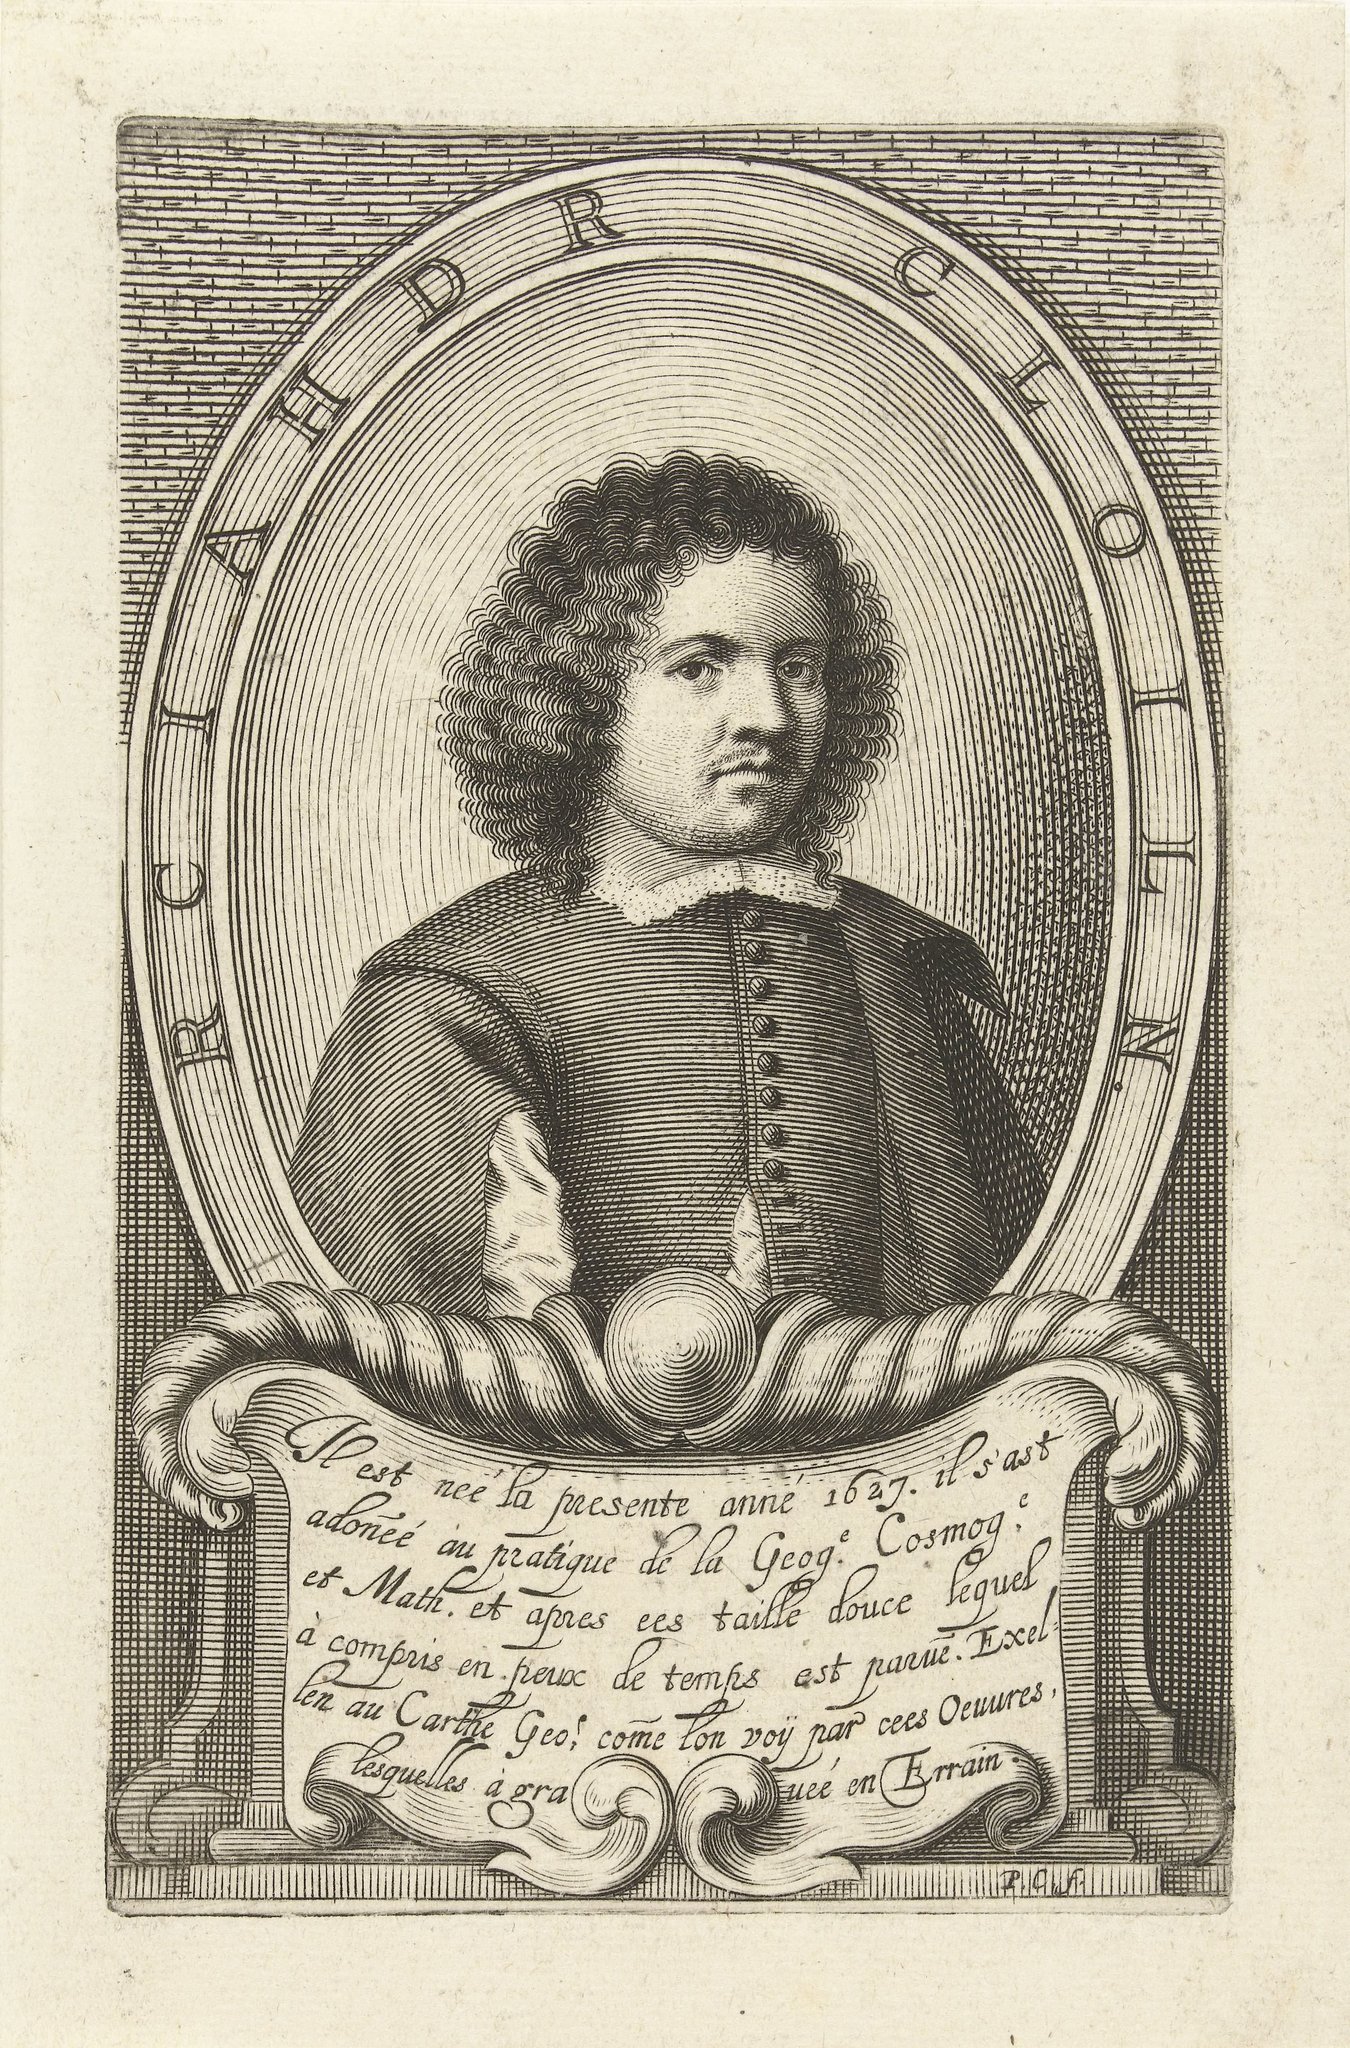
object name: print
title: Portret van Richard Collin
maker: petrus clouwet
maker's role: draughtsman, print maker, publisher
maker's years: 1629-1670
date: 1639-1670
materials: paper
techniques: engraving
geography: antwerp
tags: brussels, print maker, richard collin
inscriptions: collector's mark: Lugt 2228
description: Portret in ovale lijst van Richard Collin, een Vlaamse prentmaker en uitgever. Buste naar rechts. De prent heeft een Frans onderschrift.